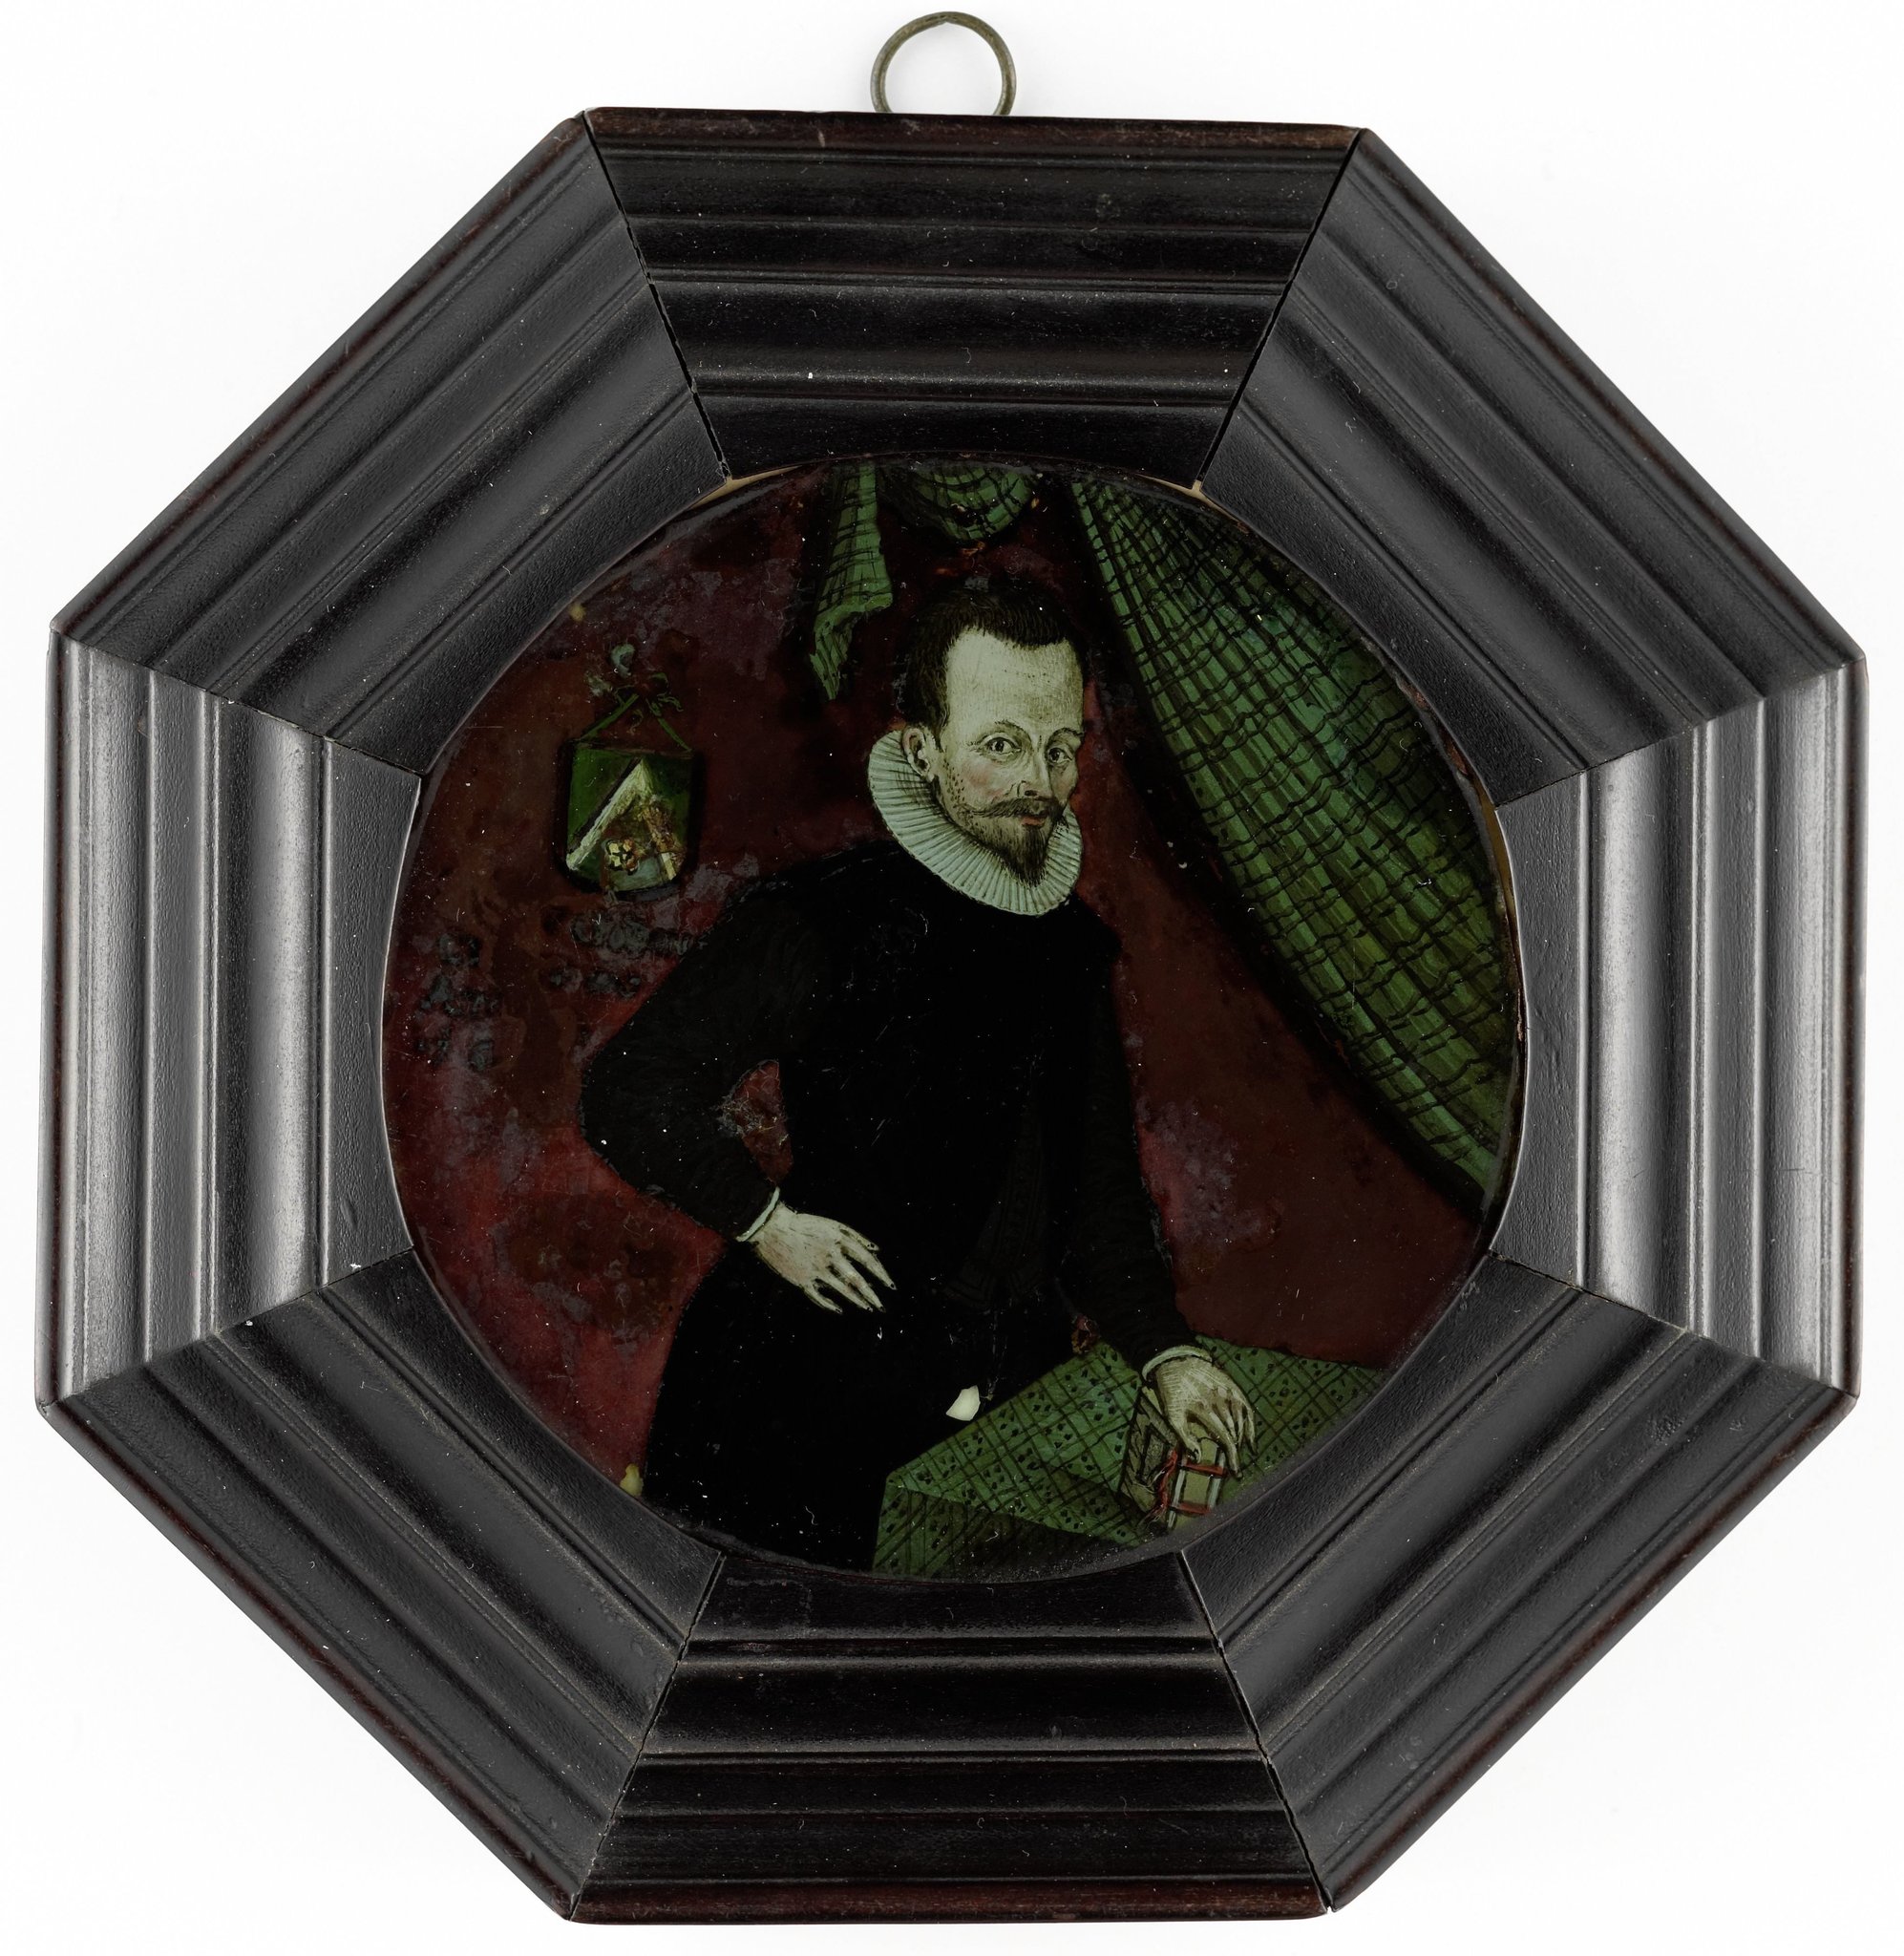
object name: painting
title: Portrait of a Man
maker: Anonymous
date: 1595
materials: glass, wood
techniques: verre églomisé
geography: netherlands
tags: historical persons not known by name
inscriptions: inscription and date: ‘GISOW GS ... AE16’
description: Portret van een man. Ten halven lijve, staande bij een tafel met de linkerhand steunend op een boek en de rechterhand in de zij. Linksboven het familiewapen.